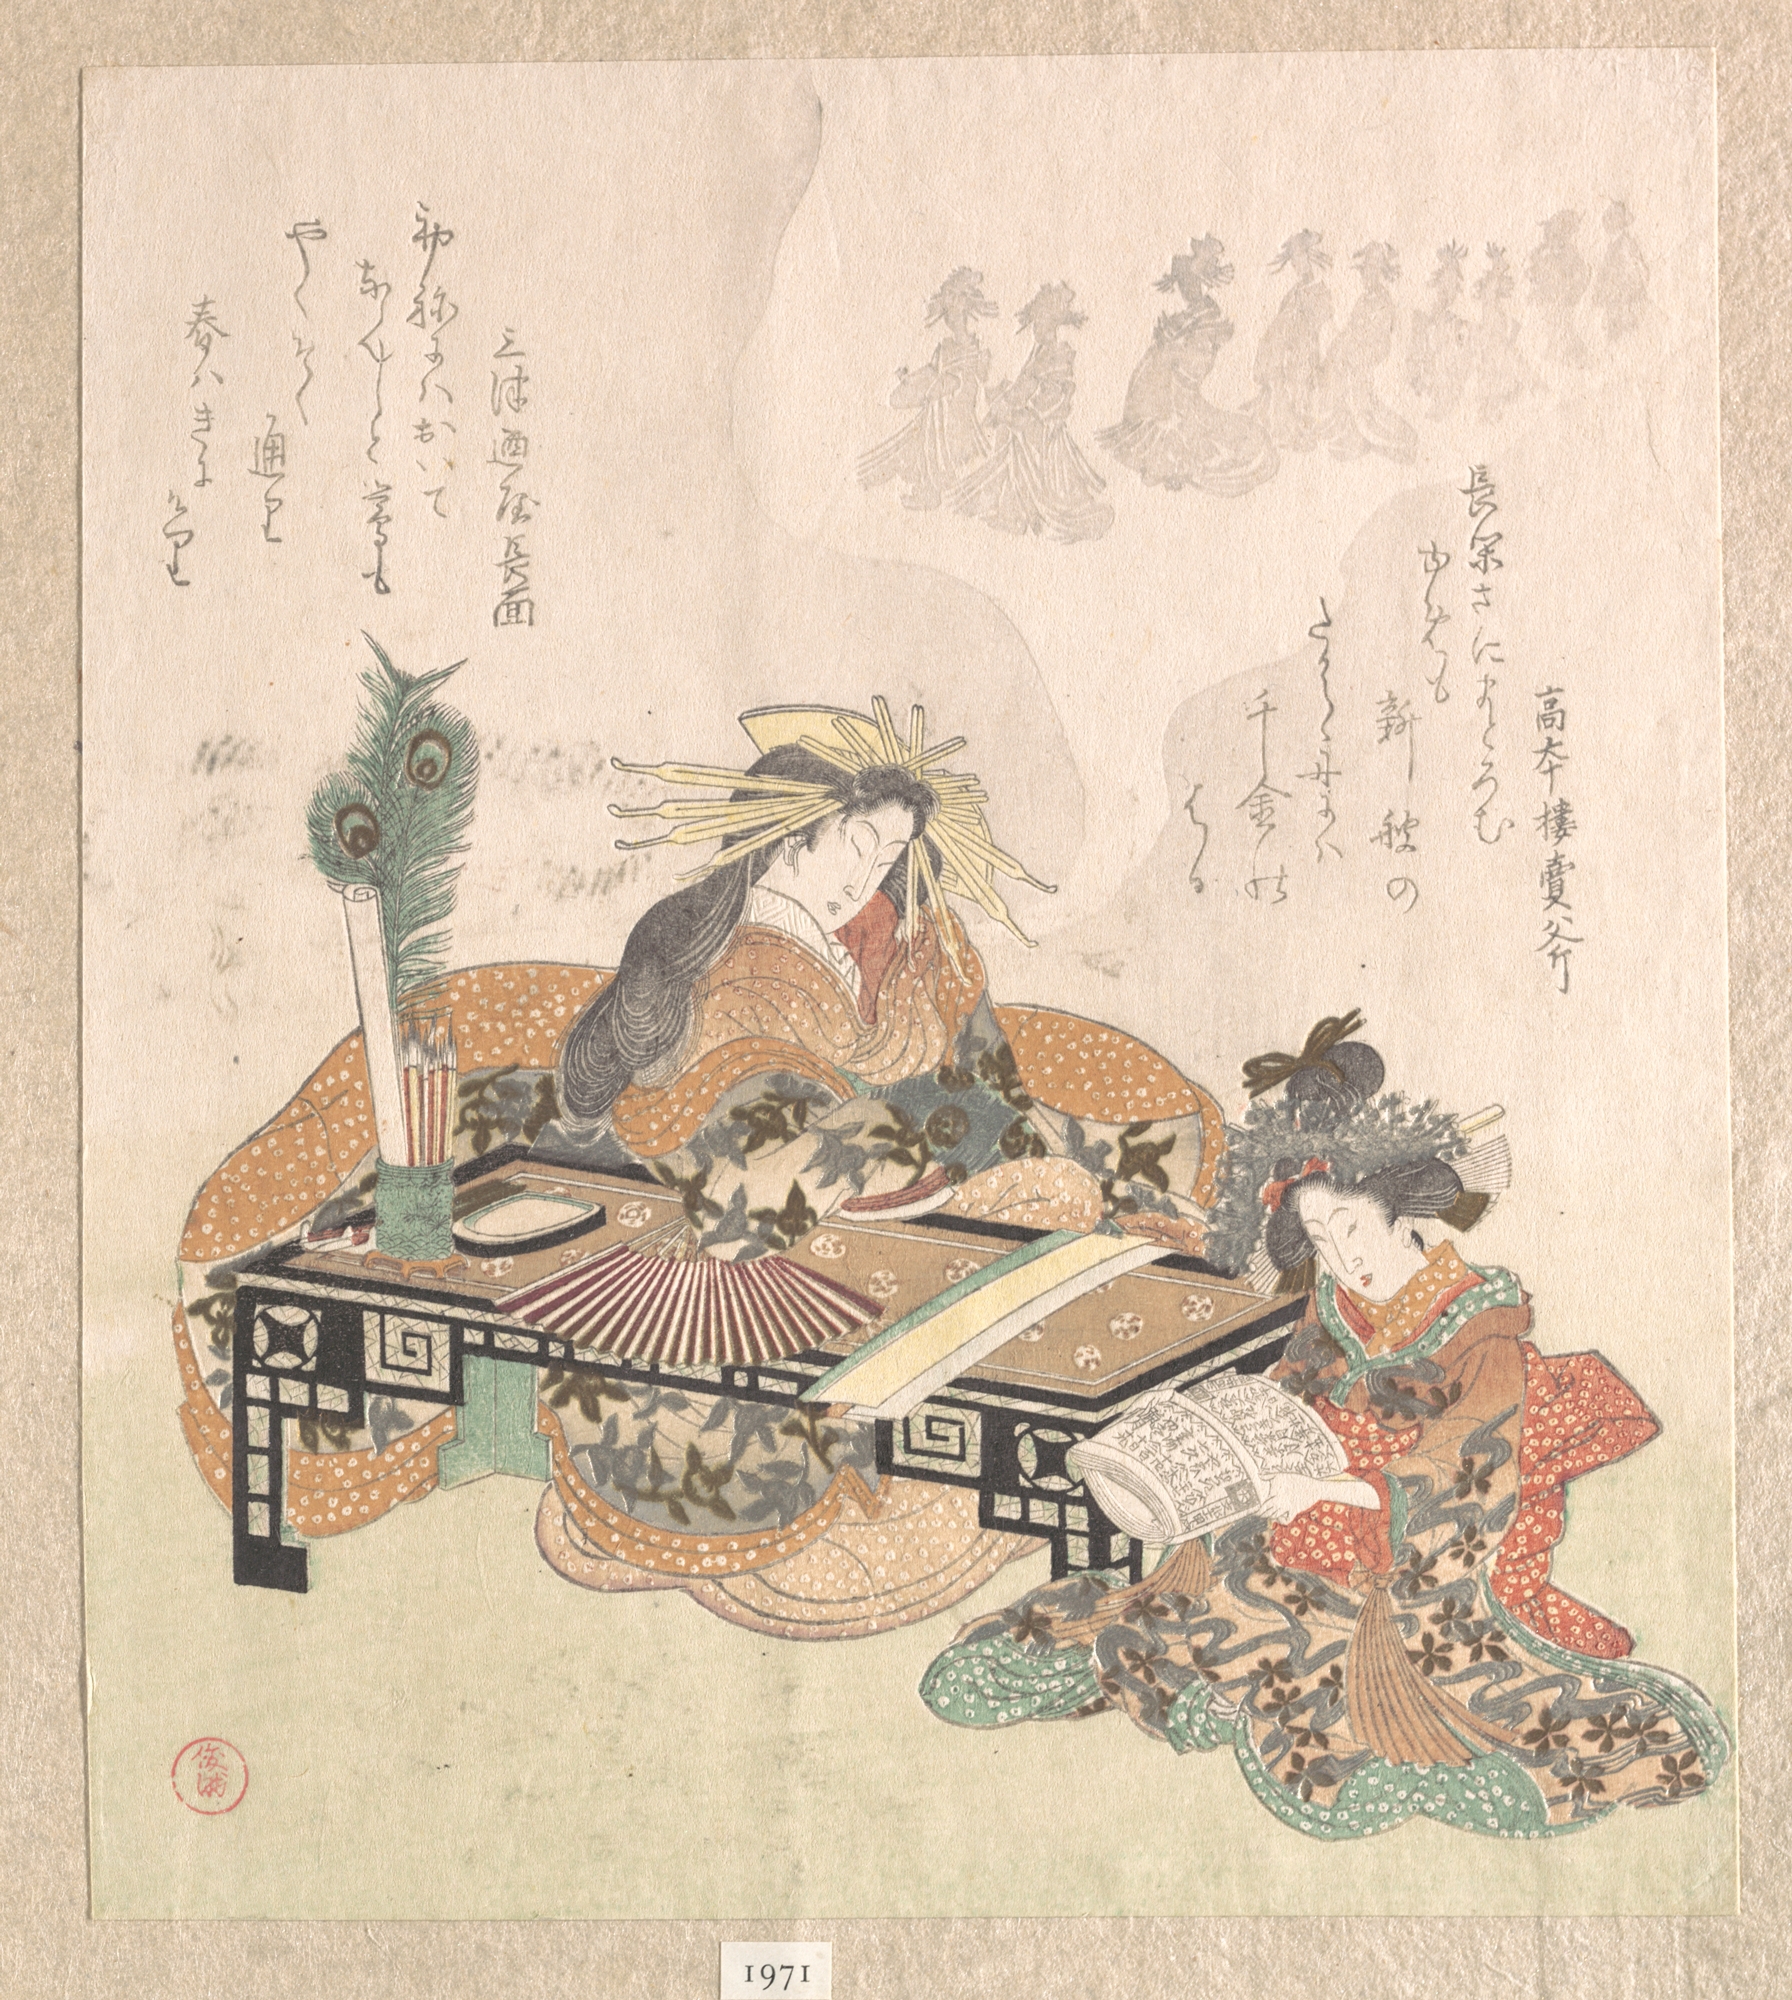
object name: print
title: Courtesan Dreaming of the New Year Procession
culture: japanese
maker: kubo shunman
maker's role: artist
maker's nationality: japanese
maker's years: 1757-1820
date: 1814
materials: ink, paper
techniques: surimono, woodblock print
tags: fans,women,reading